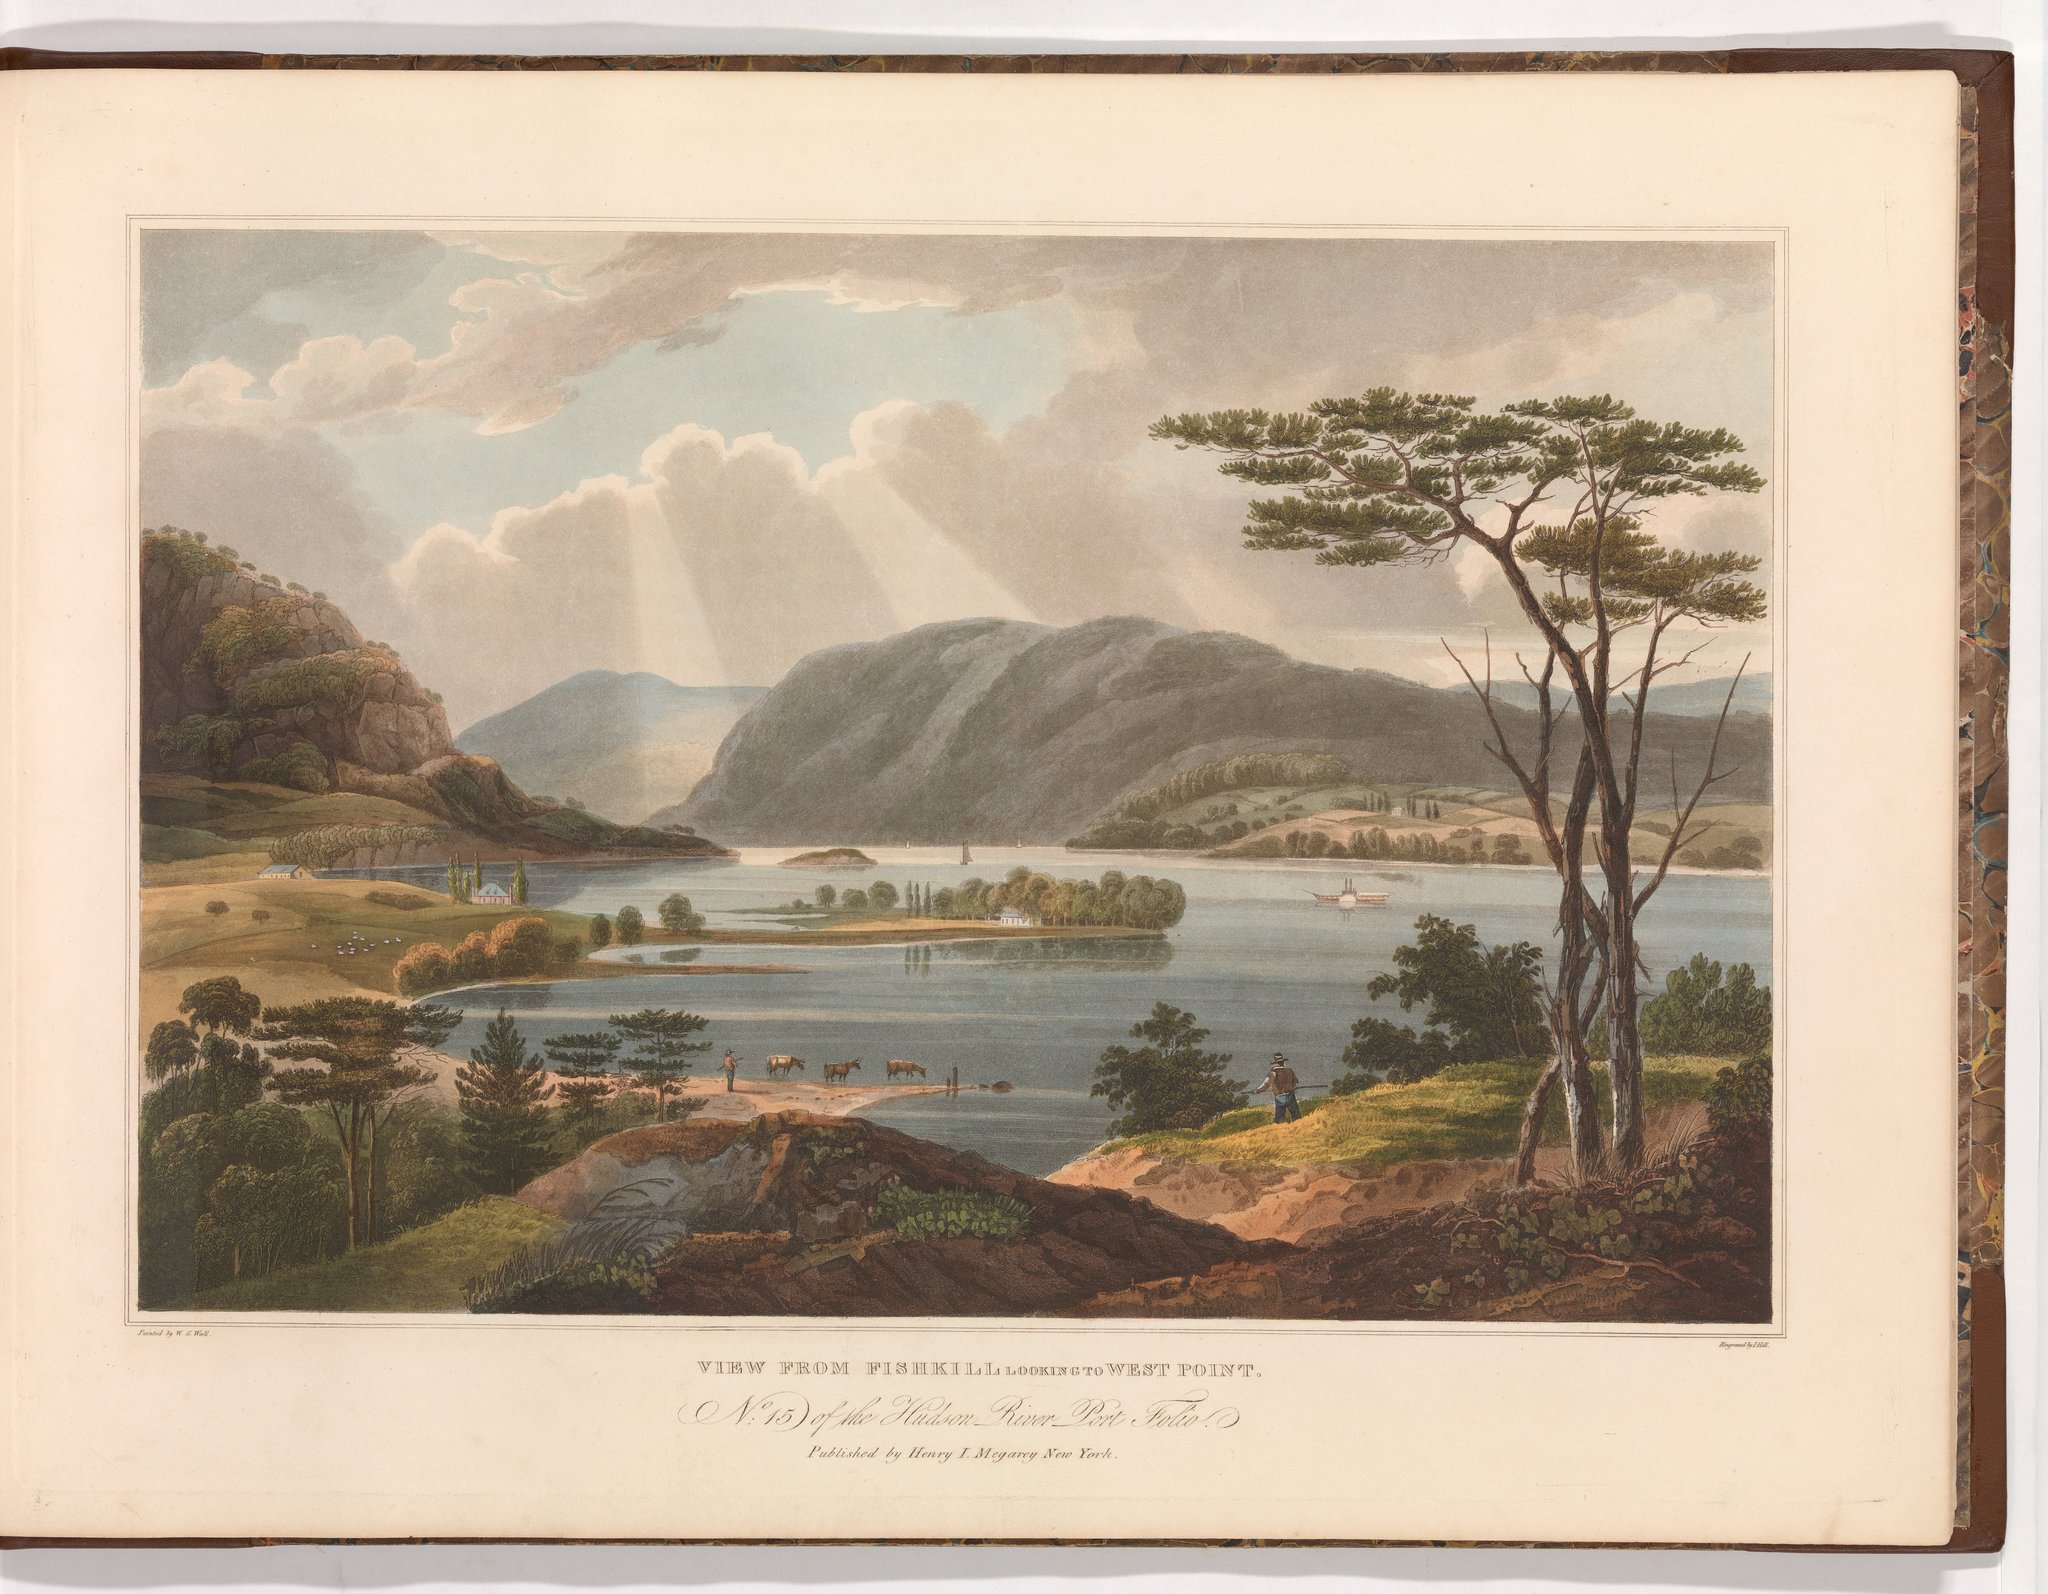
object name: print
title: View from Fishkill Looking To West-Point (No. 15 of The Hudson River Portfolio)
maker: john rubens smith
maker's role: etcher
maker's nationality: american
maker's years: 1775-1849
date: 1825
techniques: aquatint, hand coloring, printing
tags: rivers,mountains,landscapes,trees